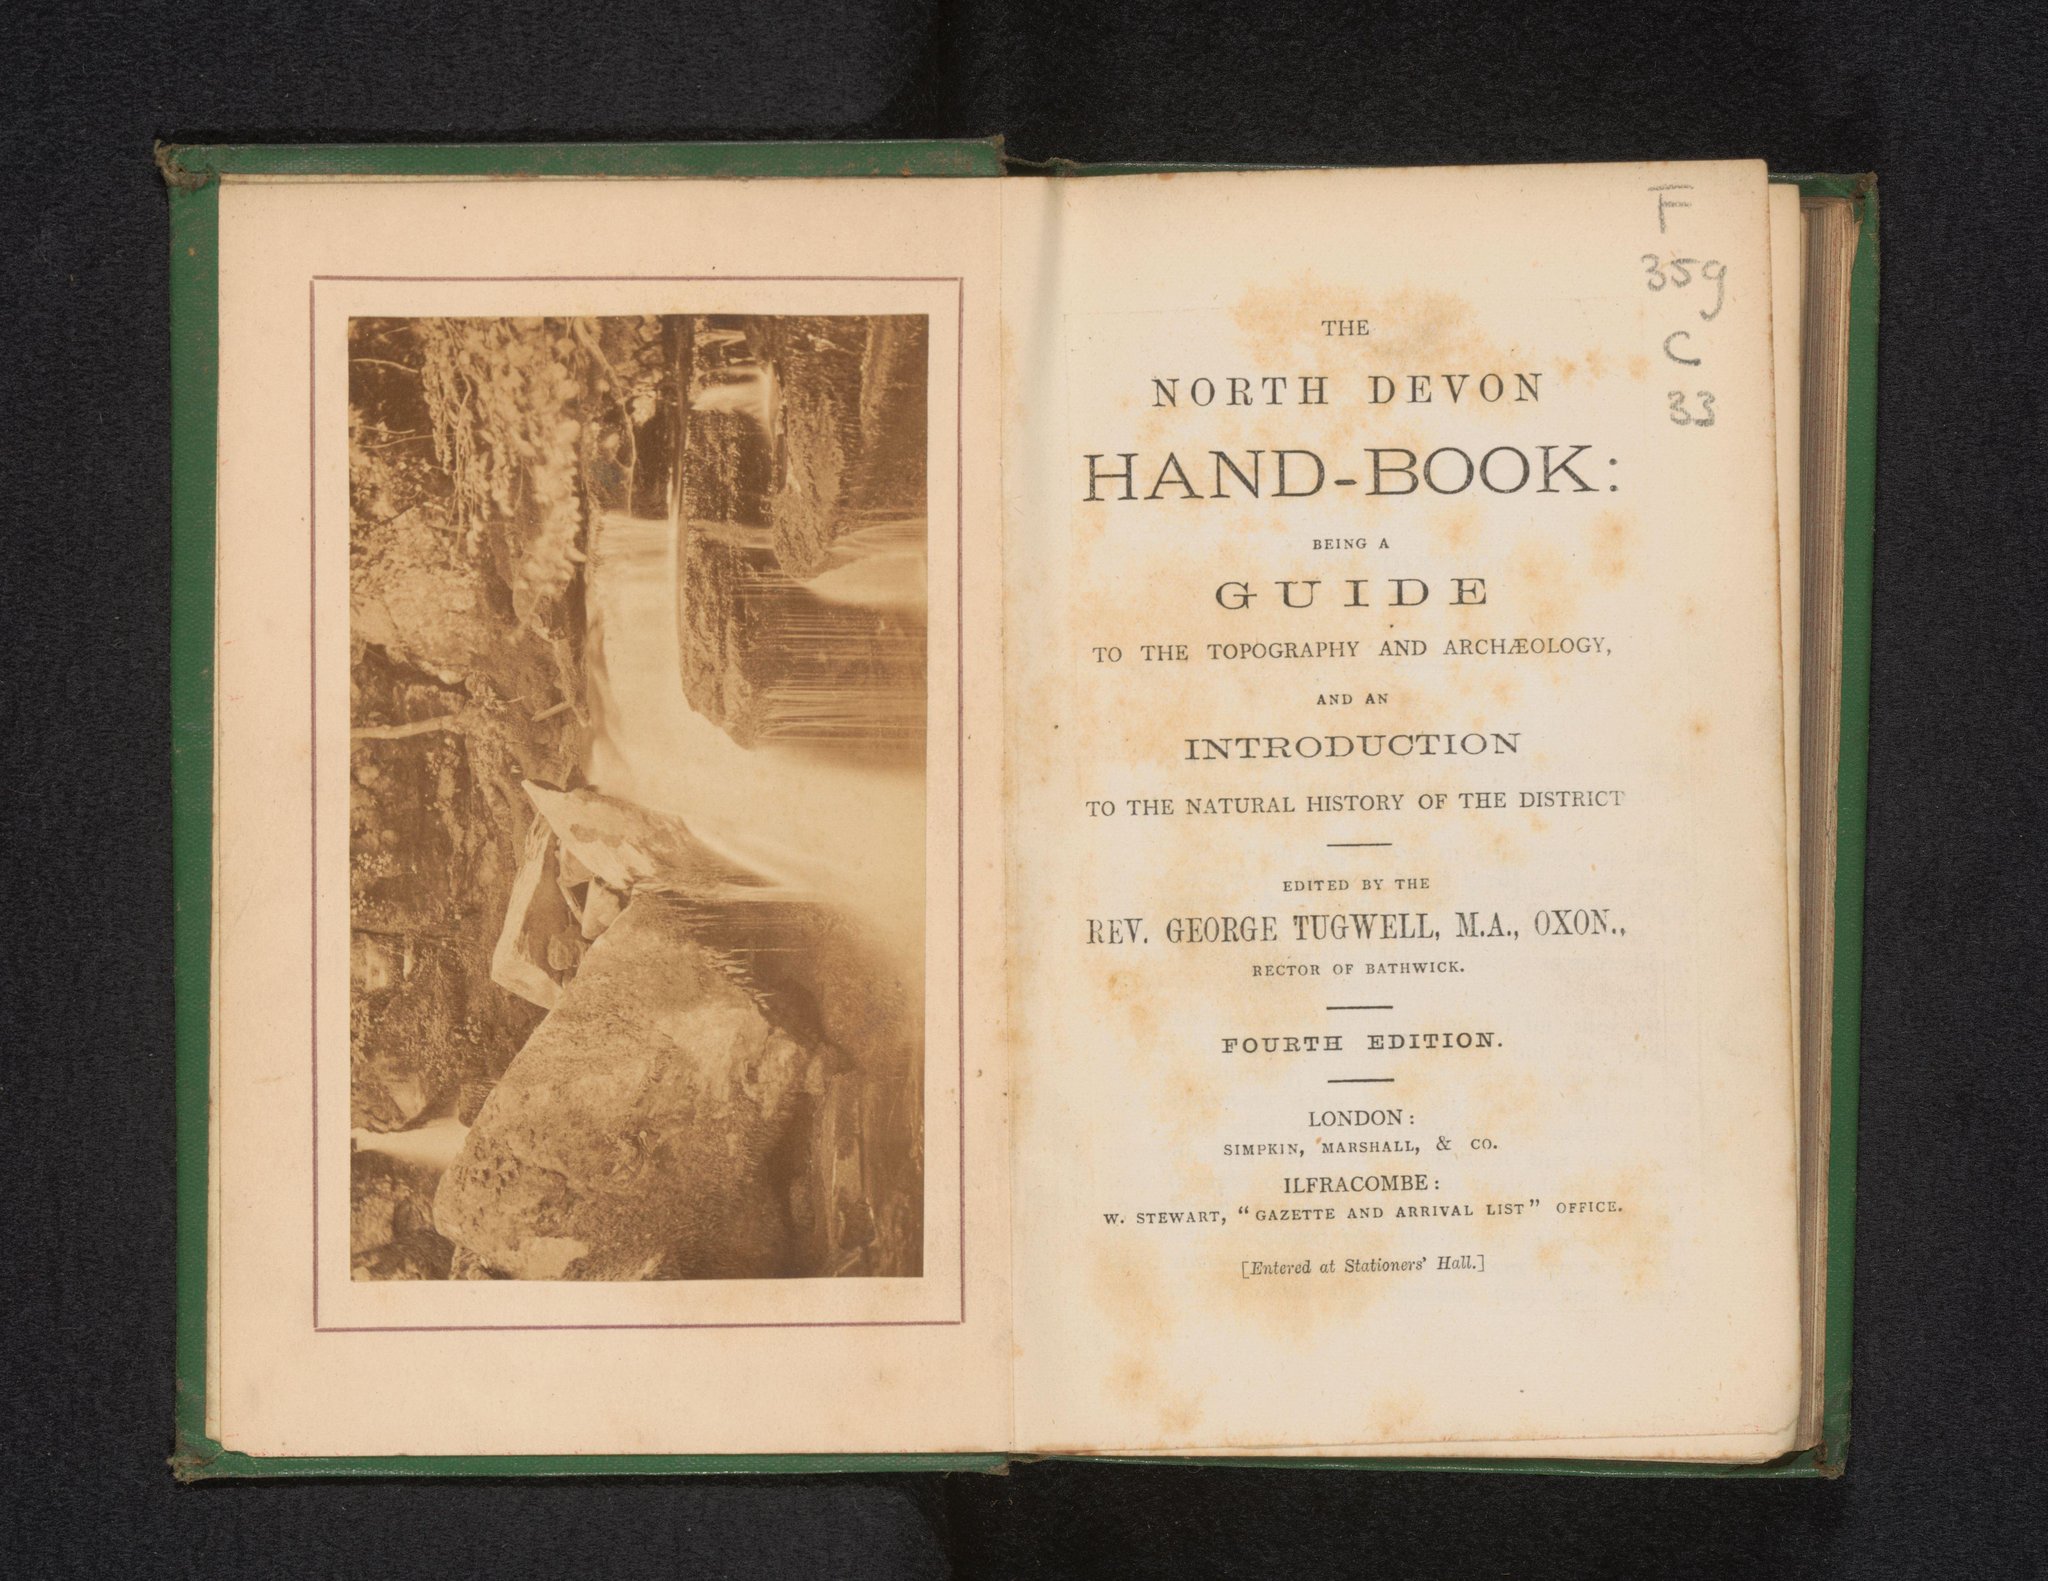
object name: photograph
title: Gezicht op een waterval in Devon, Engeland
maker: Anonymous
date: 1872-1877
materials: photographic support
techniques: albumen print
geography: devon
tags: waterfall